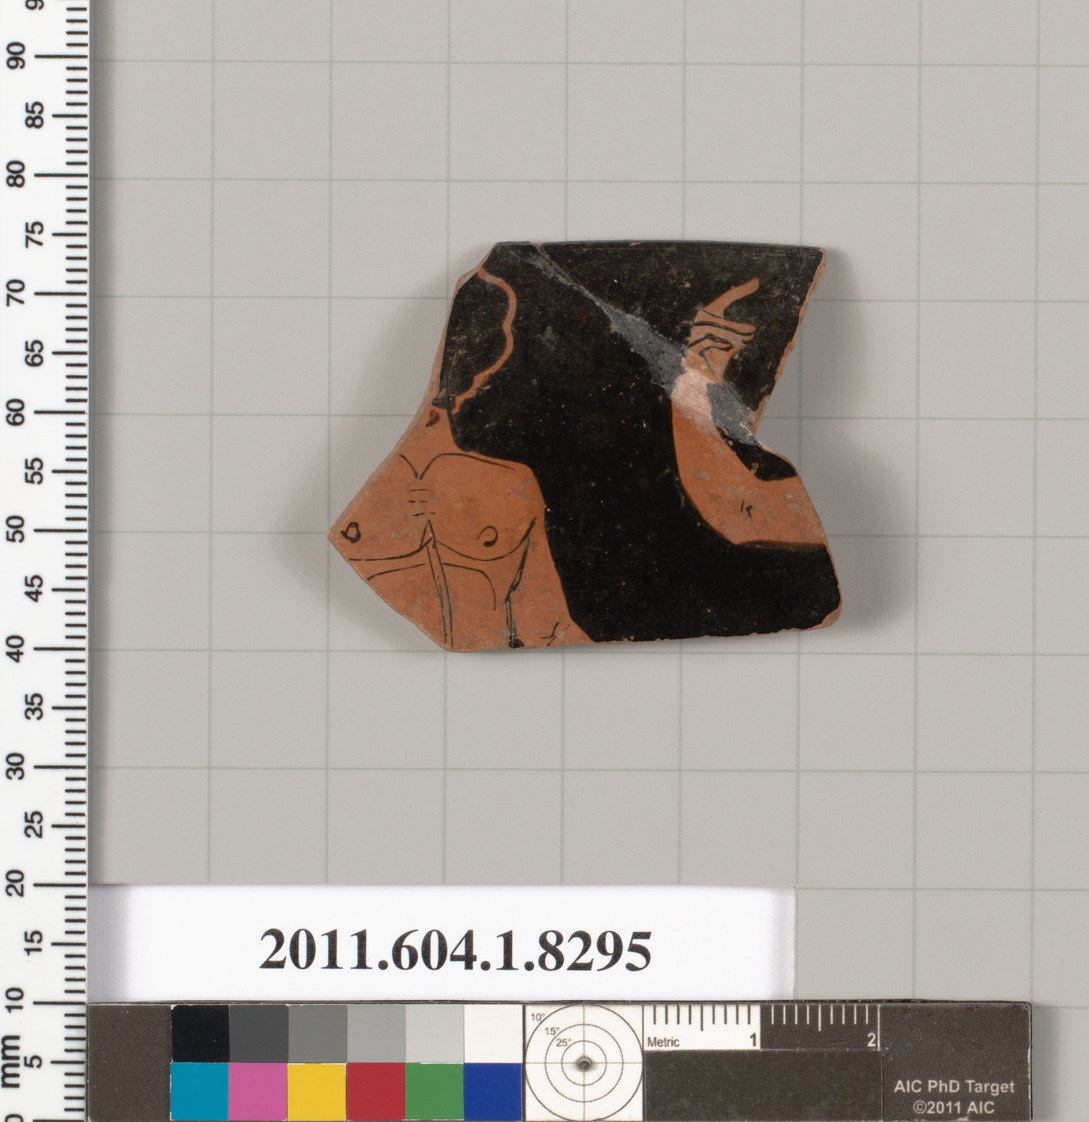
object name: kylix fragment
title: Terracotta rim fragment of a kylix (drinking cup)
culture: greek, attic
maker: painter of london e 106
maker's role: artist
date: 425-401 BCE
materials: terracotta